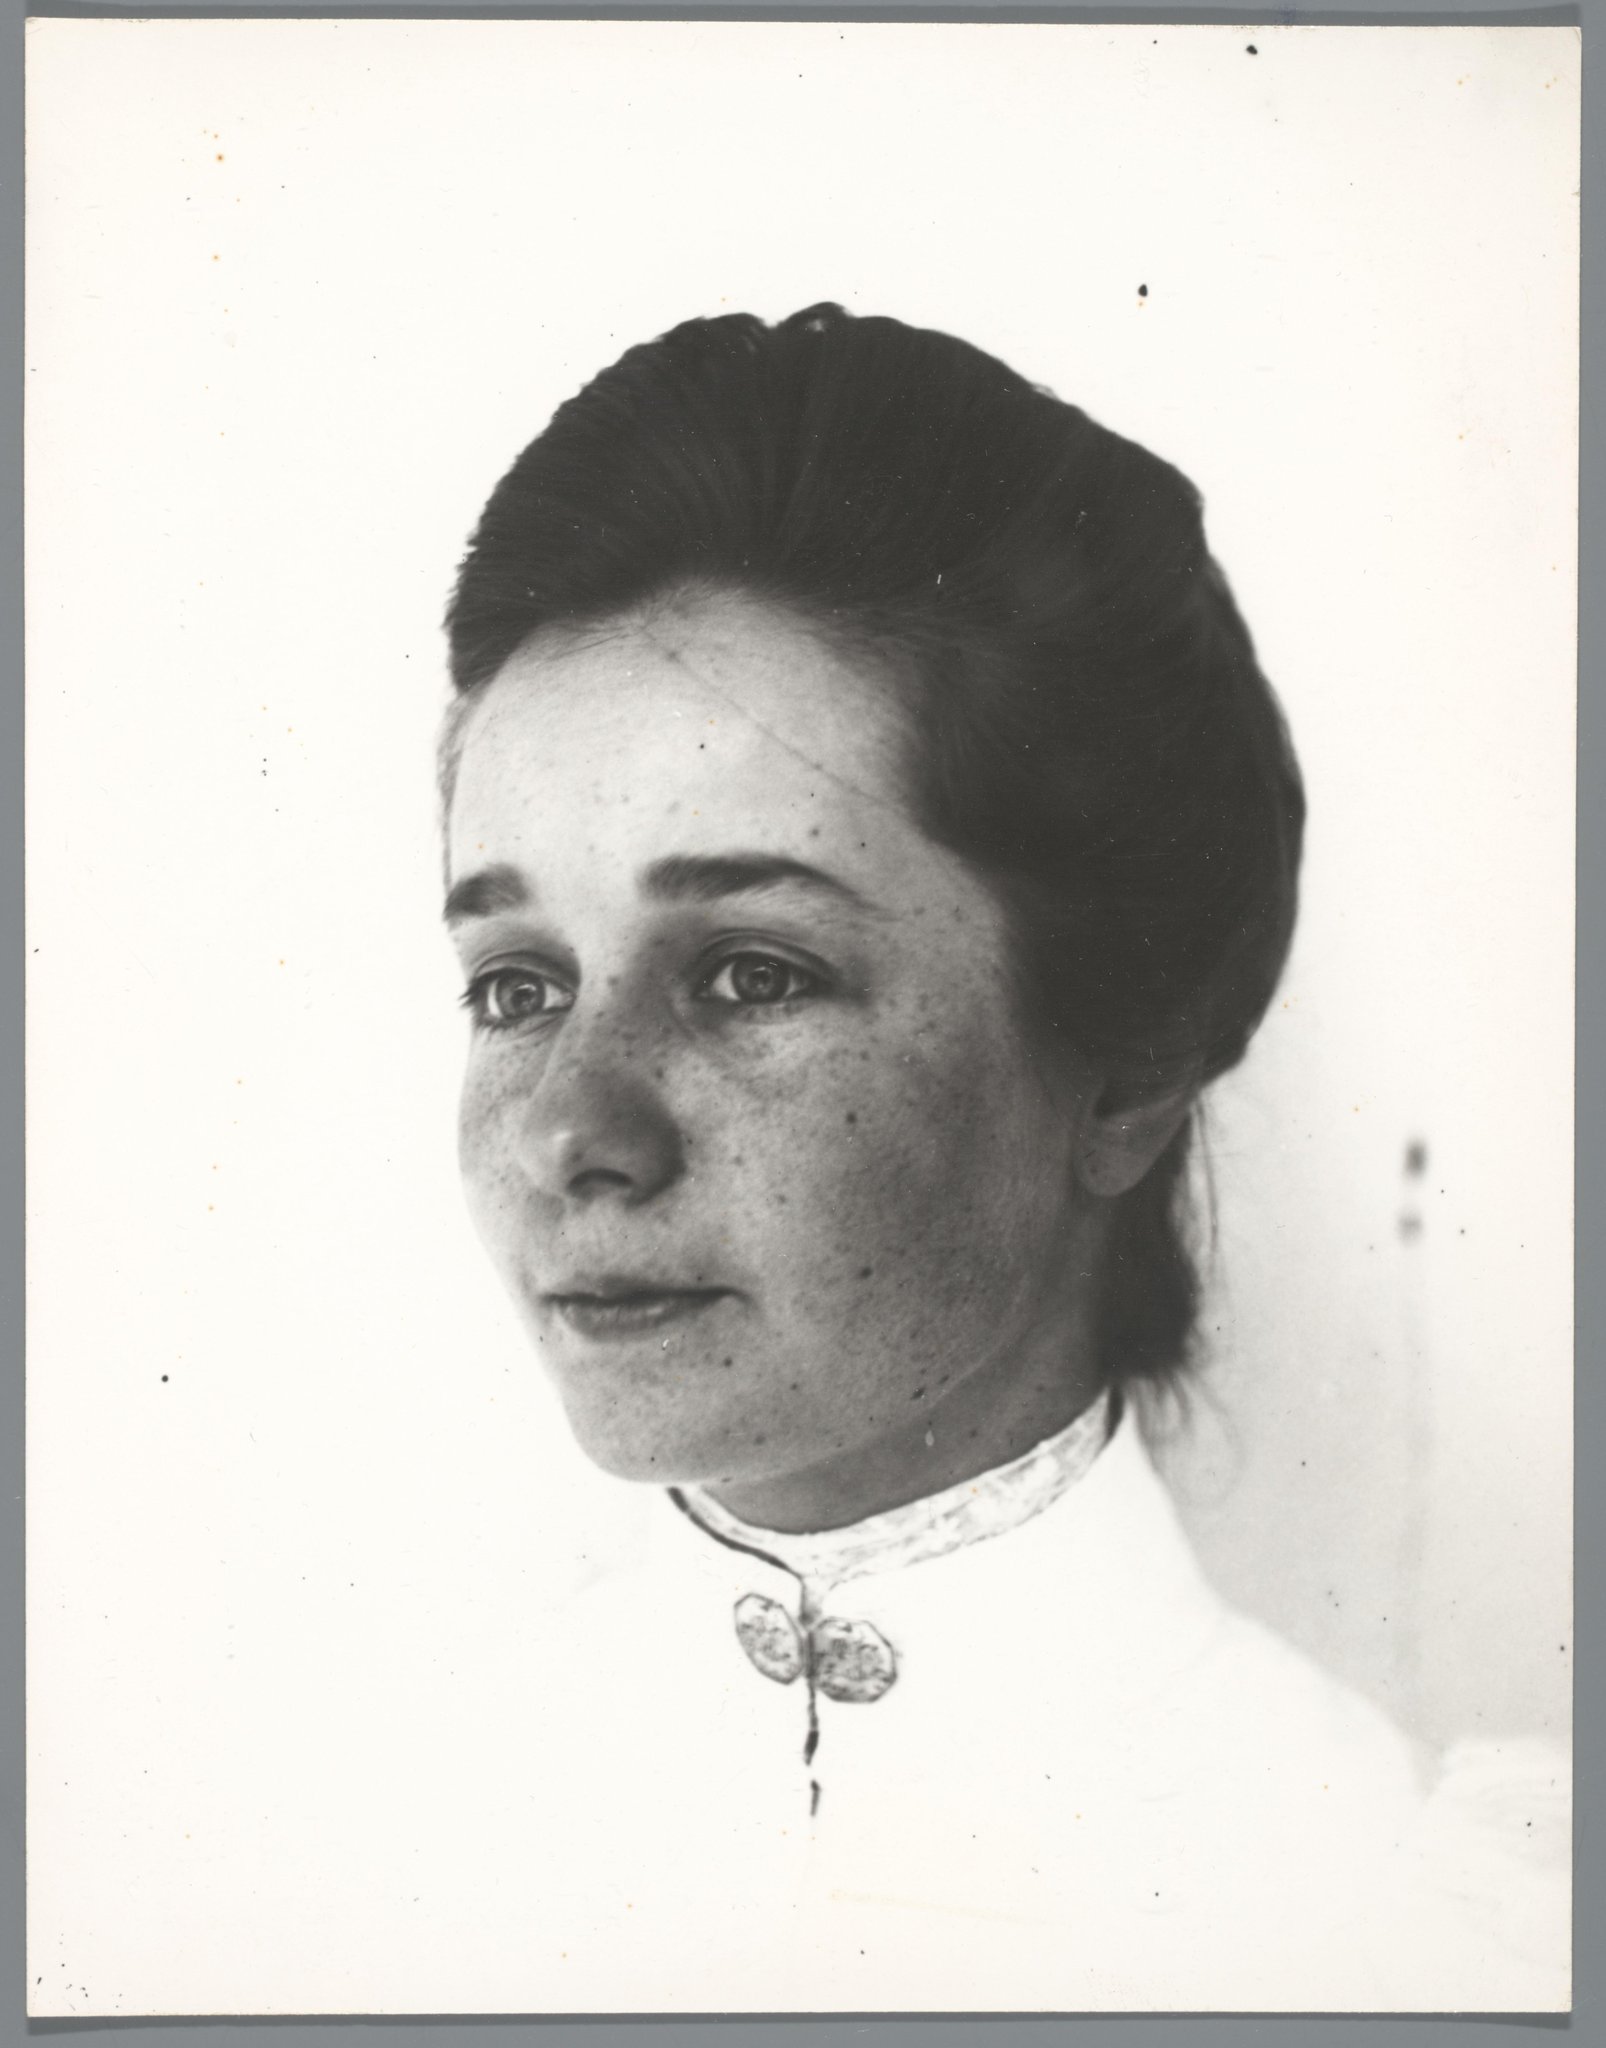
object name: photograph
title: Portret van een onbekende vrouw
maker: cornelia hendrika jonker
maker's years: 1874-1924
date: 1910-1950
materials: photographic support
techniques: gelatin silver print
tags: historical persons - bb - woman